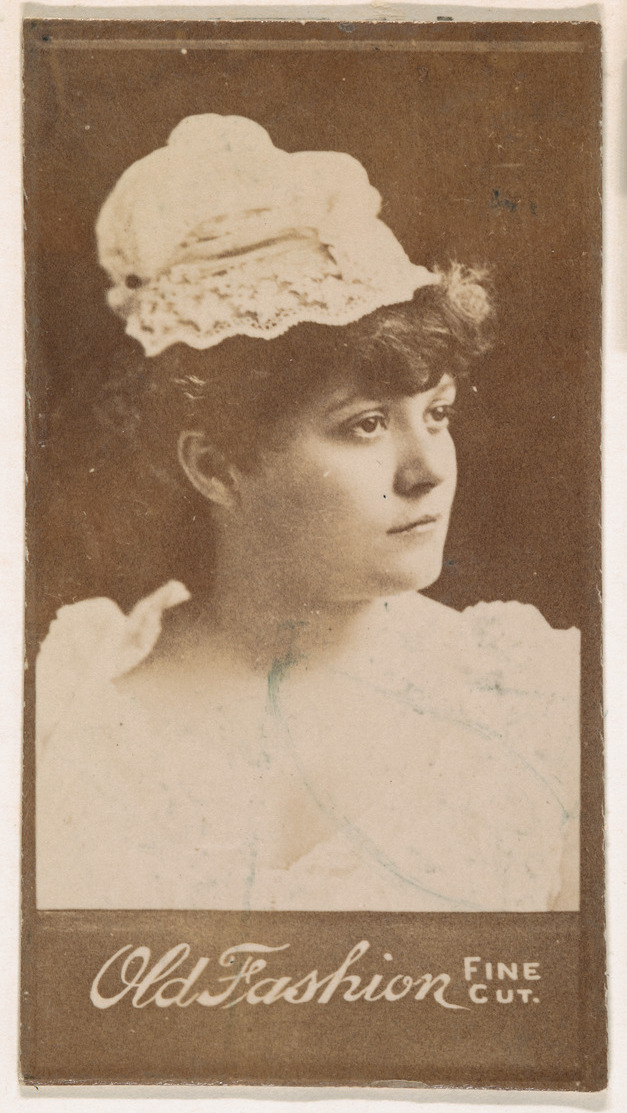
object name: photograph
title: Actress wearing lace cap, from the Actresses series (N664) promoting Old Fashion Fine Cut Tobacco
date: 1888-1890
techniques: albumen silver print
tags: portraits,women,actresses